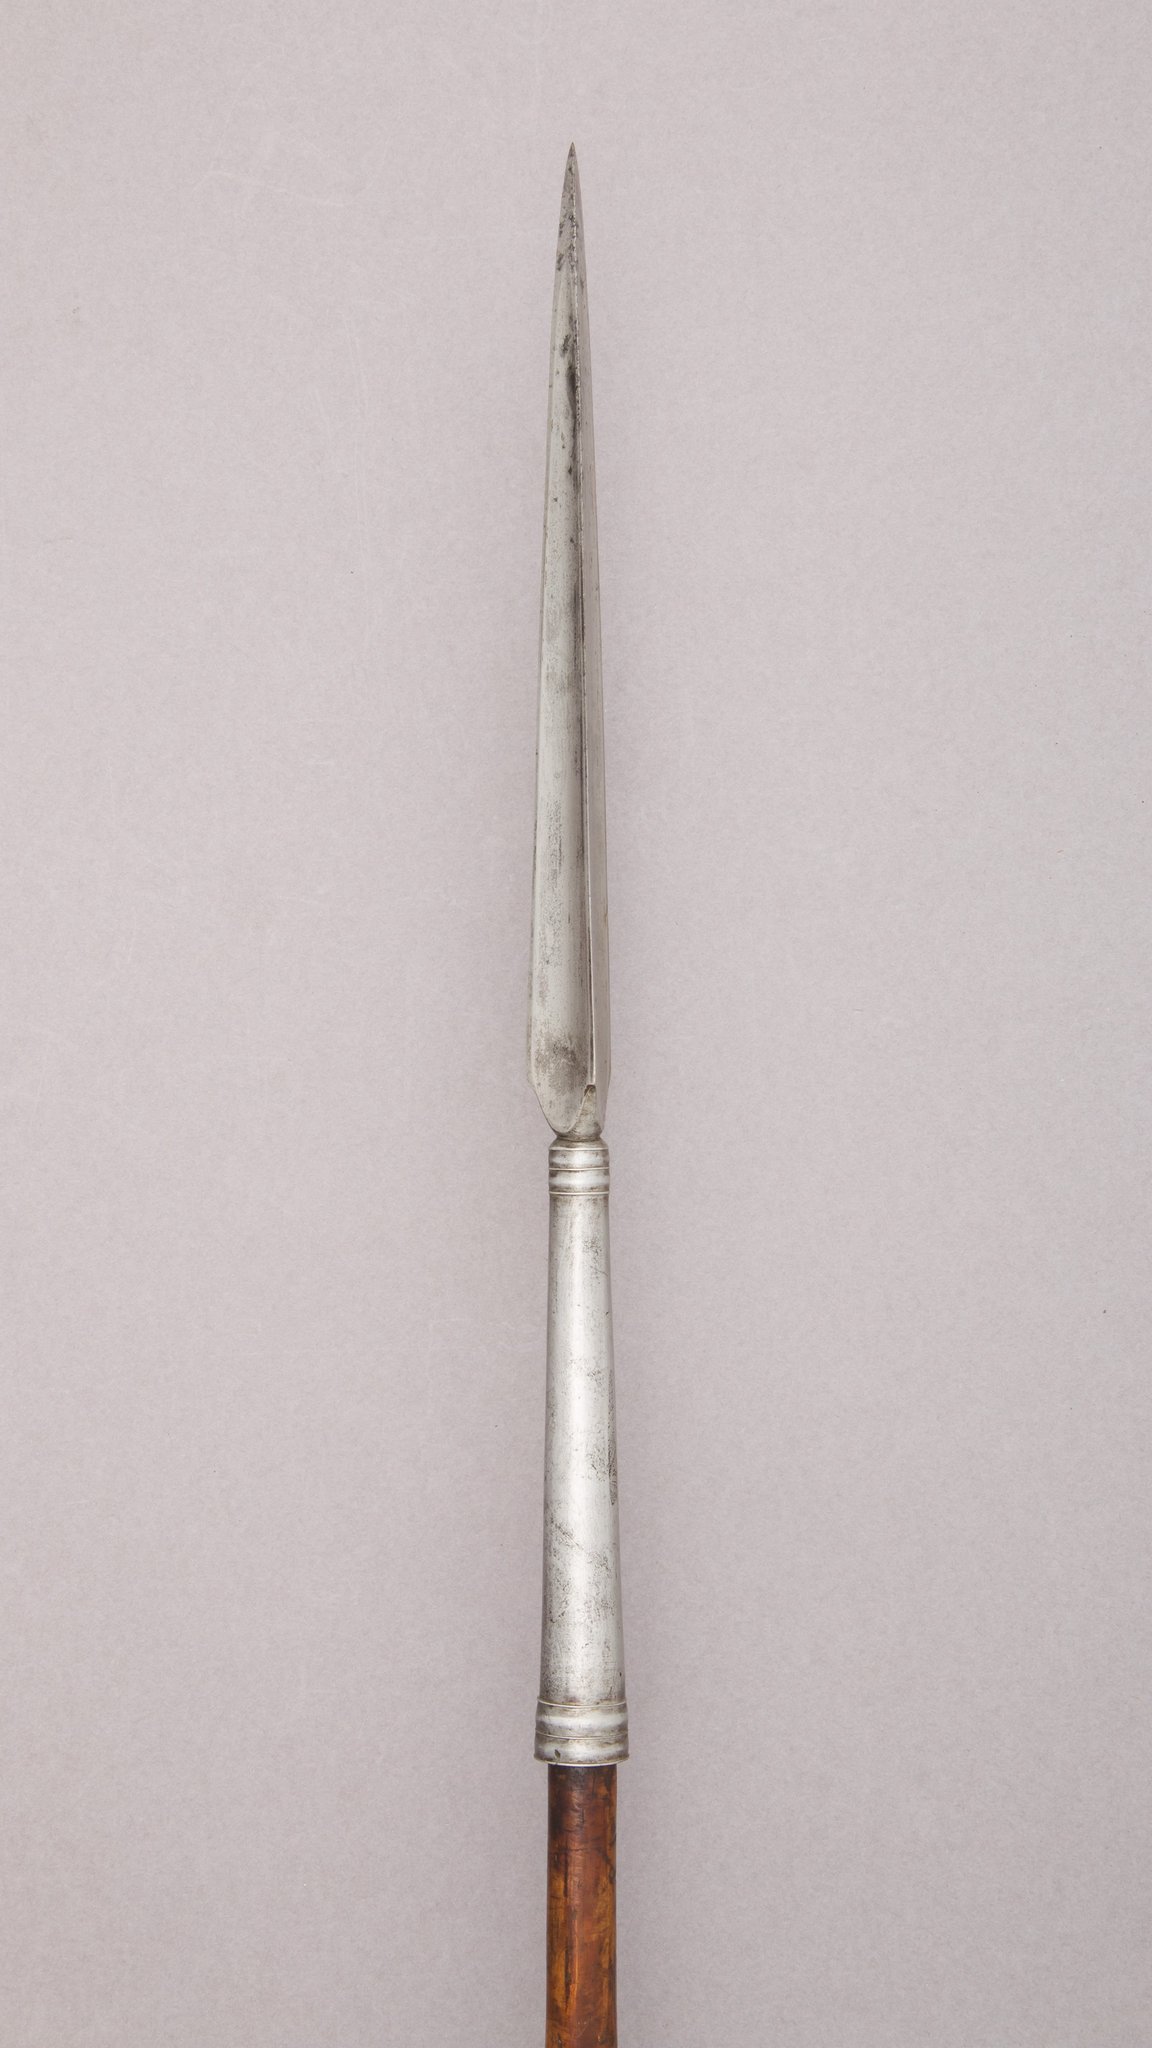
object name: lance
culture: indian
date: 1701-1900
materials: iron, steel, wood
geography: india